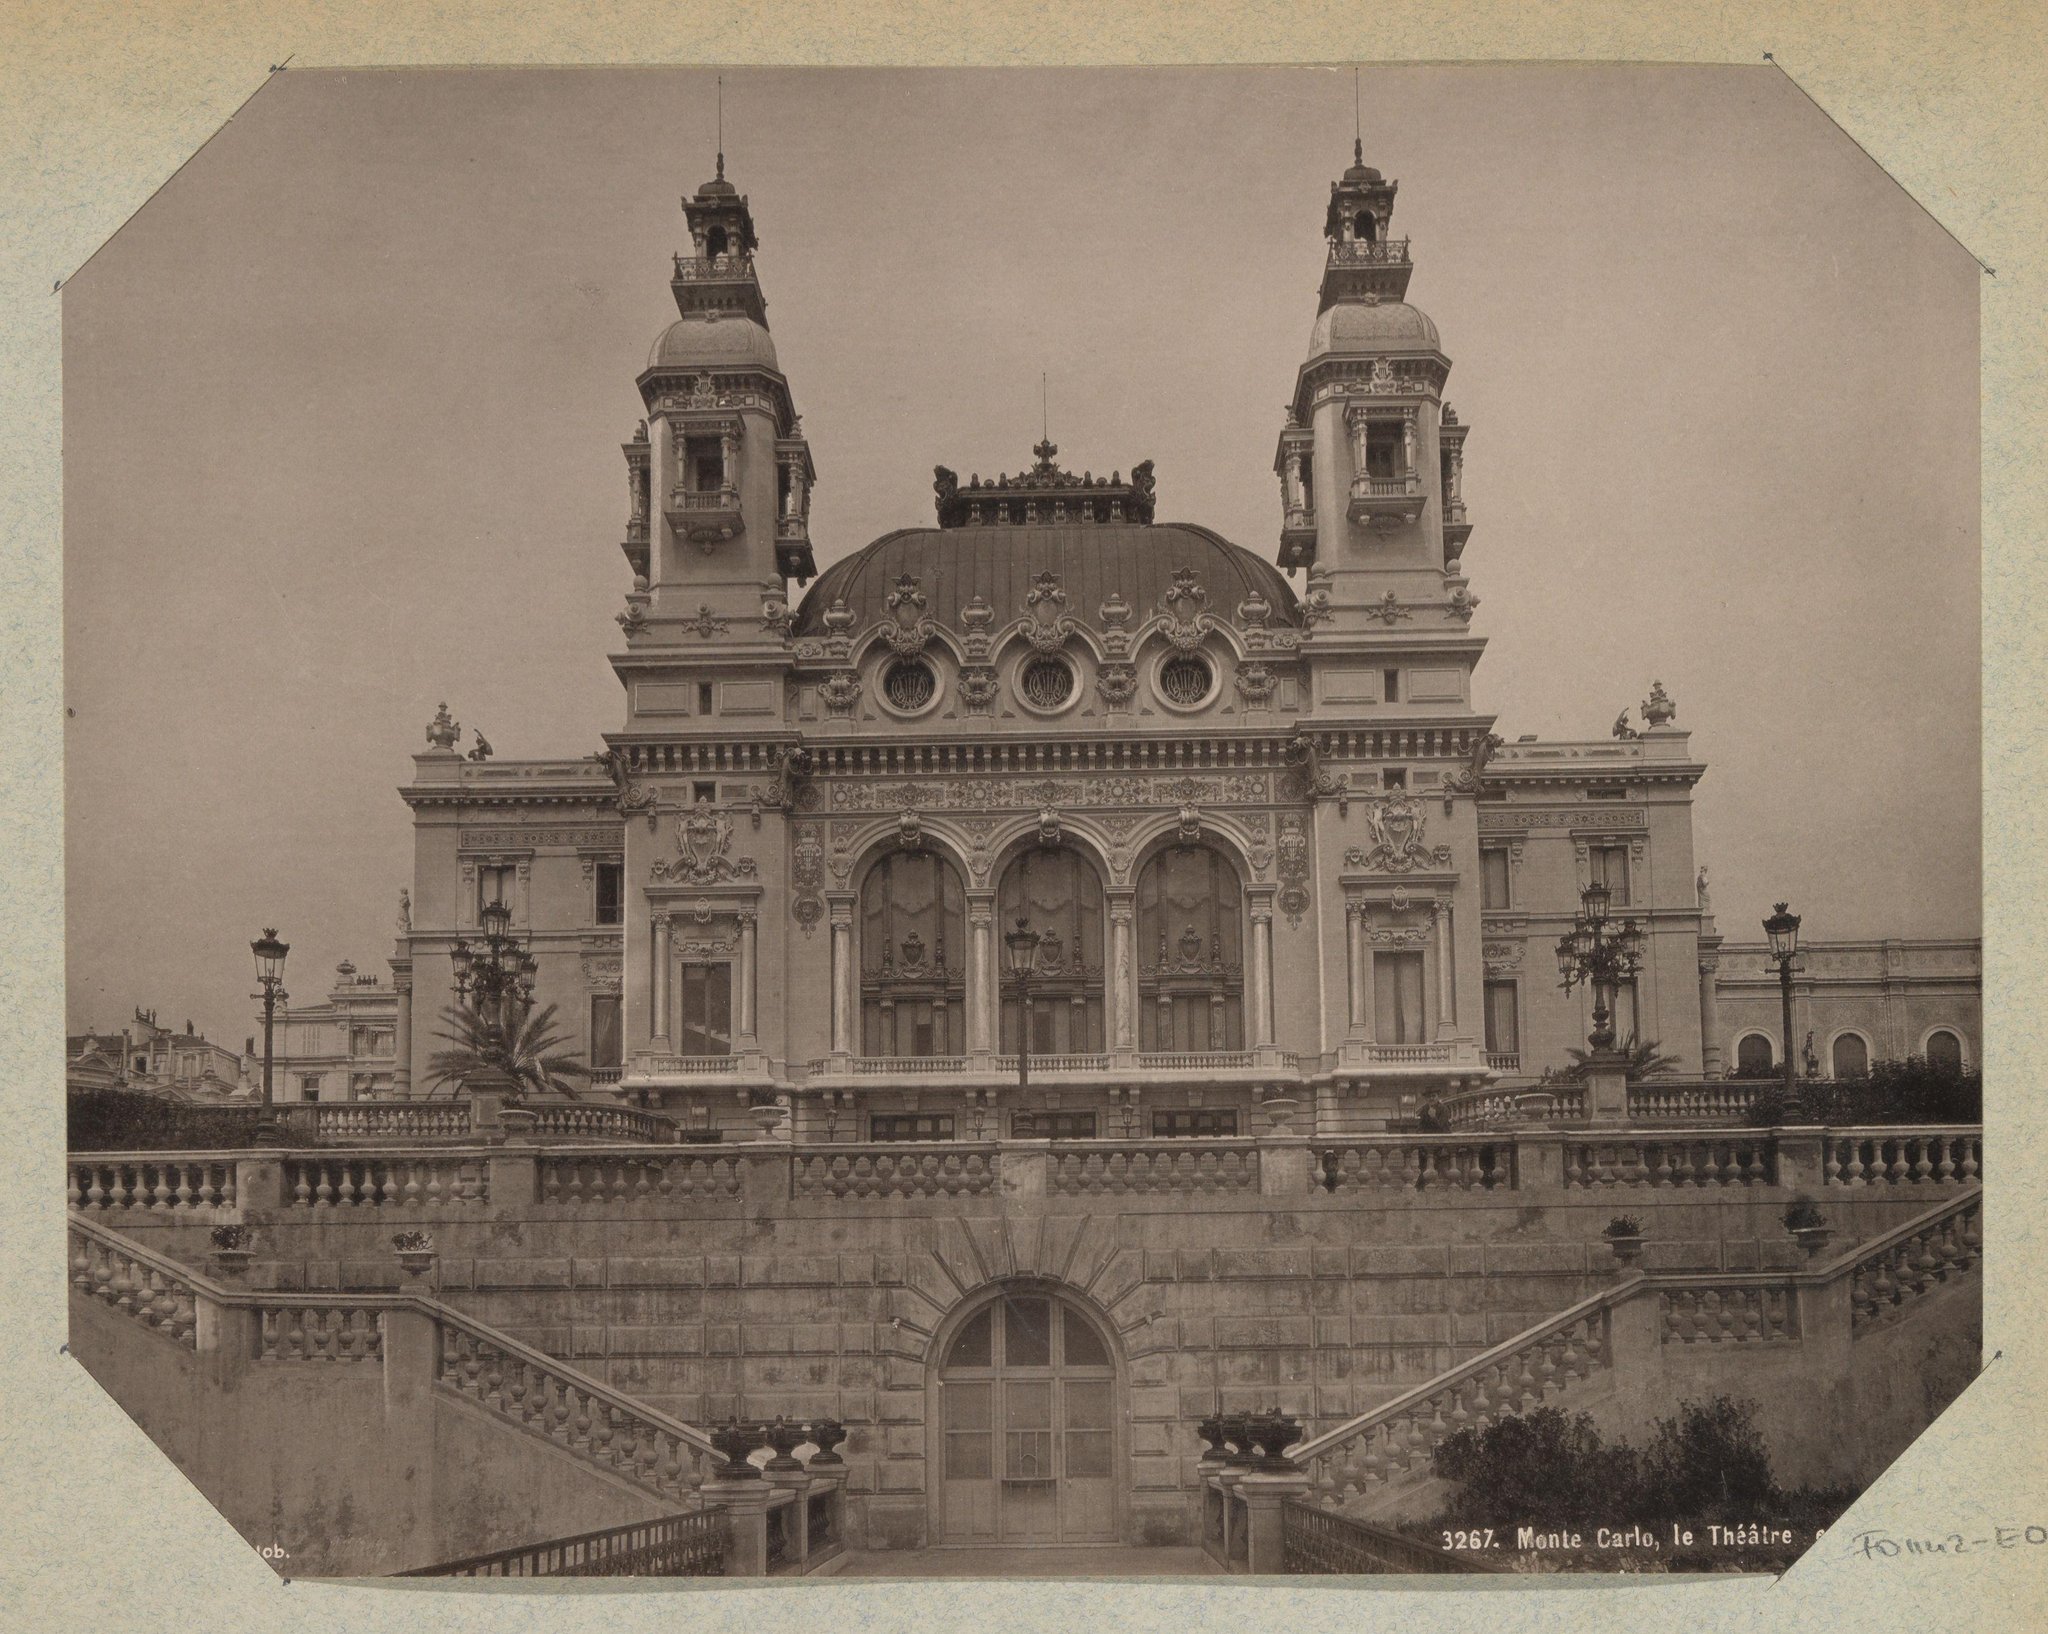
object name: photograph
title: Monte Carlo, le Théâtre en façe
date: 1890-1900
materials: paper, ink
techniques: photograph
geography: monaco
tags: theatre (building), façade (of house or building)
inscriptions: negative number: ‘3267’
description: Onderdeel van Album van een Franse amateur met foto's van Frankrijk, Algerije, Palmyra, de Wereldtentoonstelling van 1900 en van bekende Fransen.